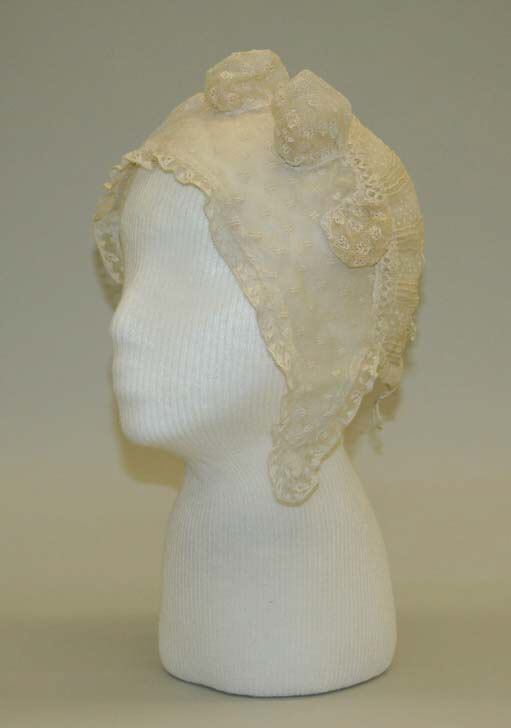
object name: cap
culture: french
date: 1804-1814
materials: cotton